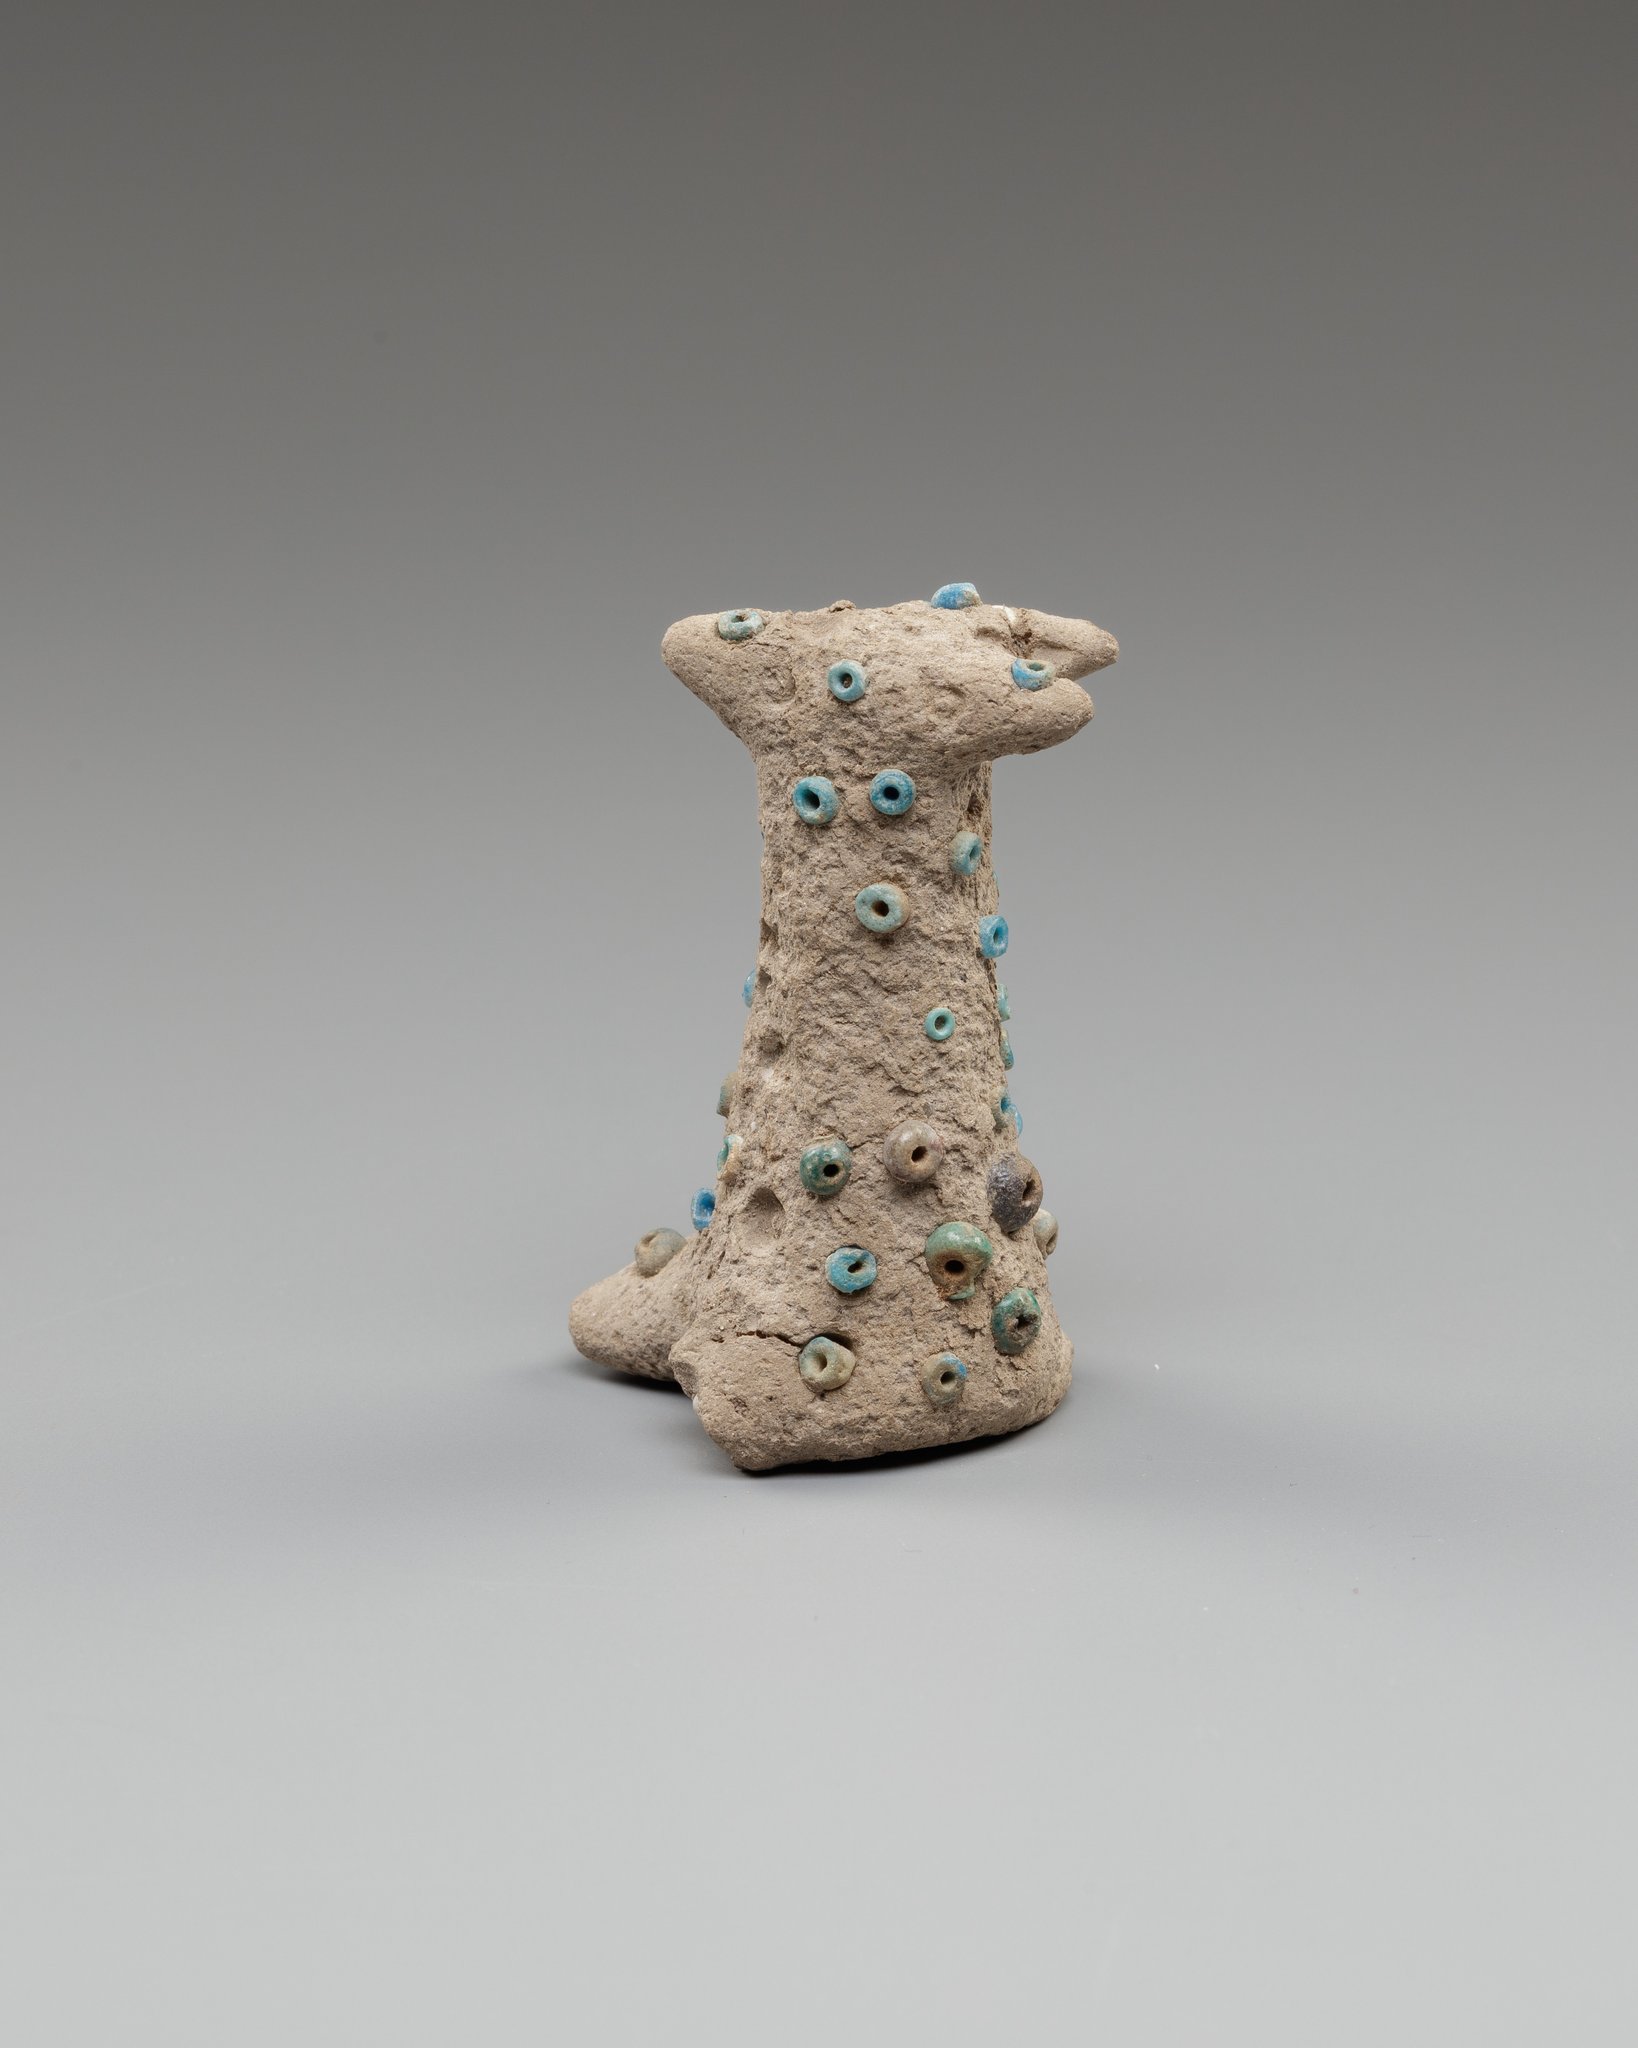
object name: figurine, animal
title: Animal figurine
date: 1981-1640 BCE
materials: clay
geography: egypt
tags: animals